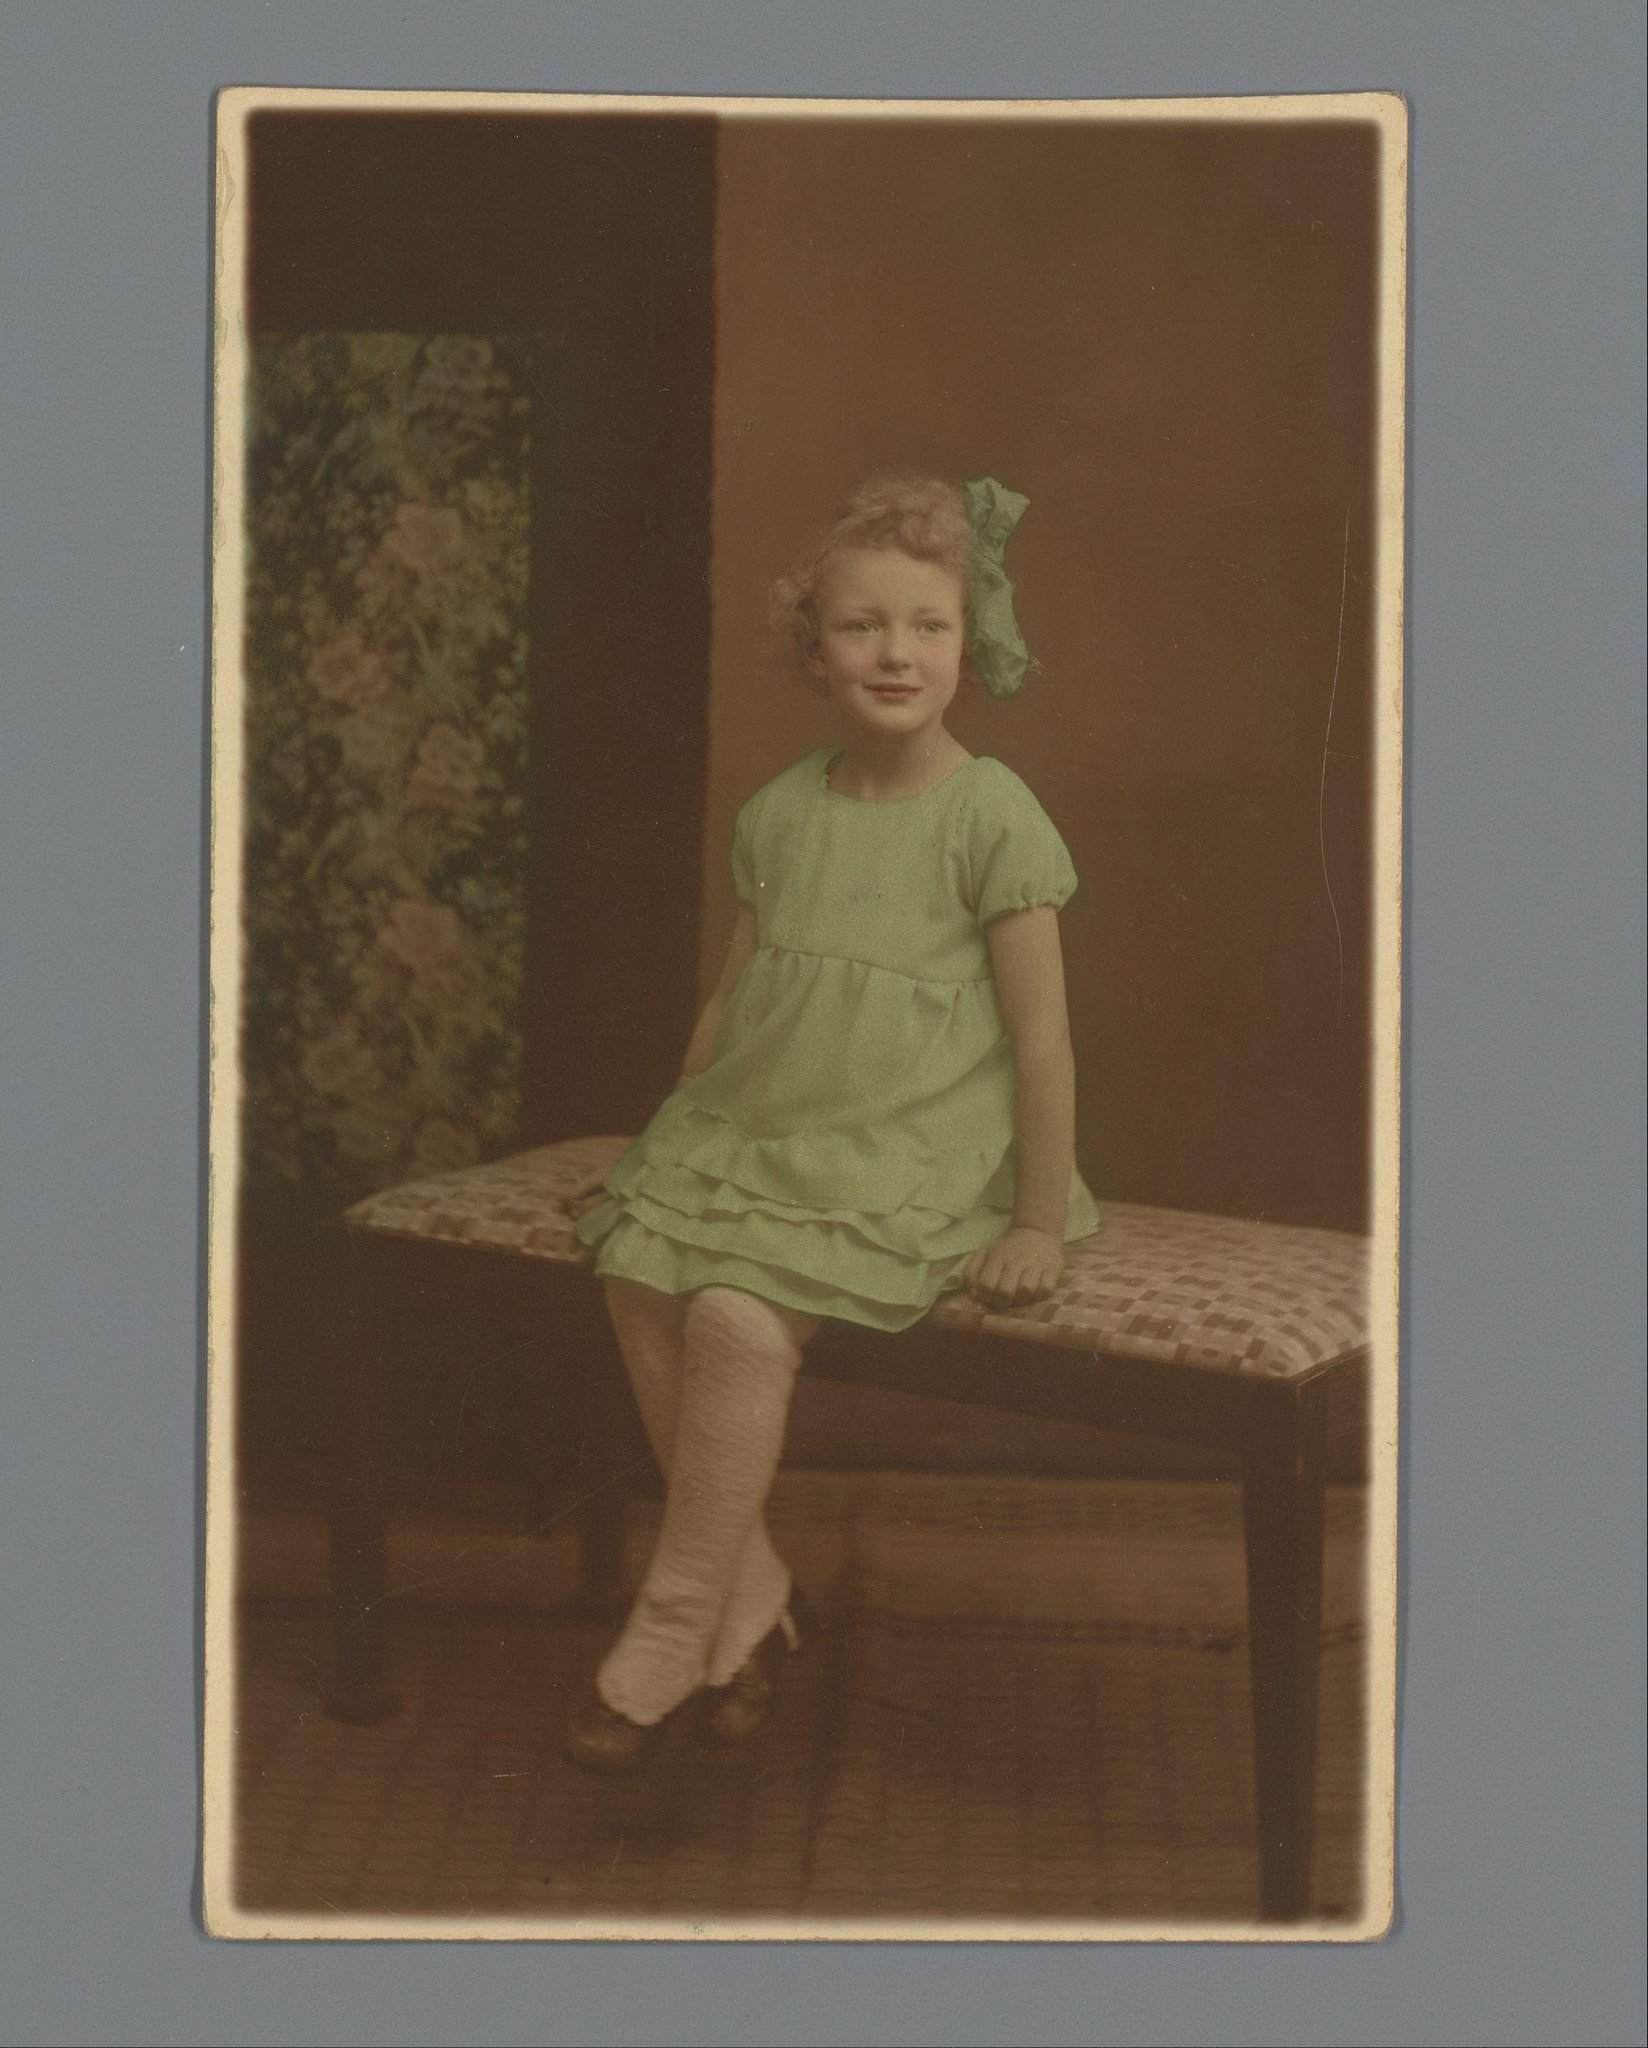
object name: photograph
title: Portret van een onbekend meisje in groene jurk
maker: bernard marie becker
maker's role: fotograaf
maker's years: 1895-1971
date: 1924-1939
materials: paper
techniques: gelatin silver print, hand coloring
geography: den helder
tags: girl (child between toddler and youth), anonymous historical person portrayed, den helder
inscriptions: stamp: ‘B.M. Becker/ Weststraat 13-14/ Helder’